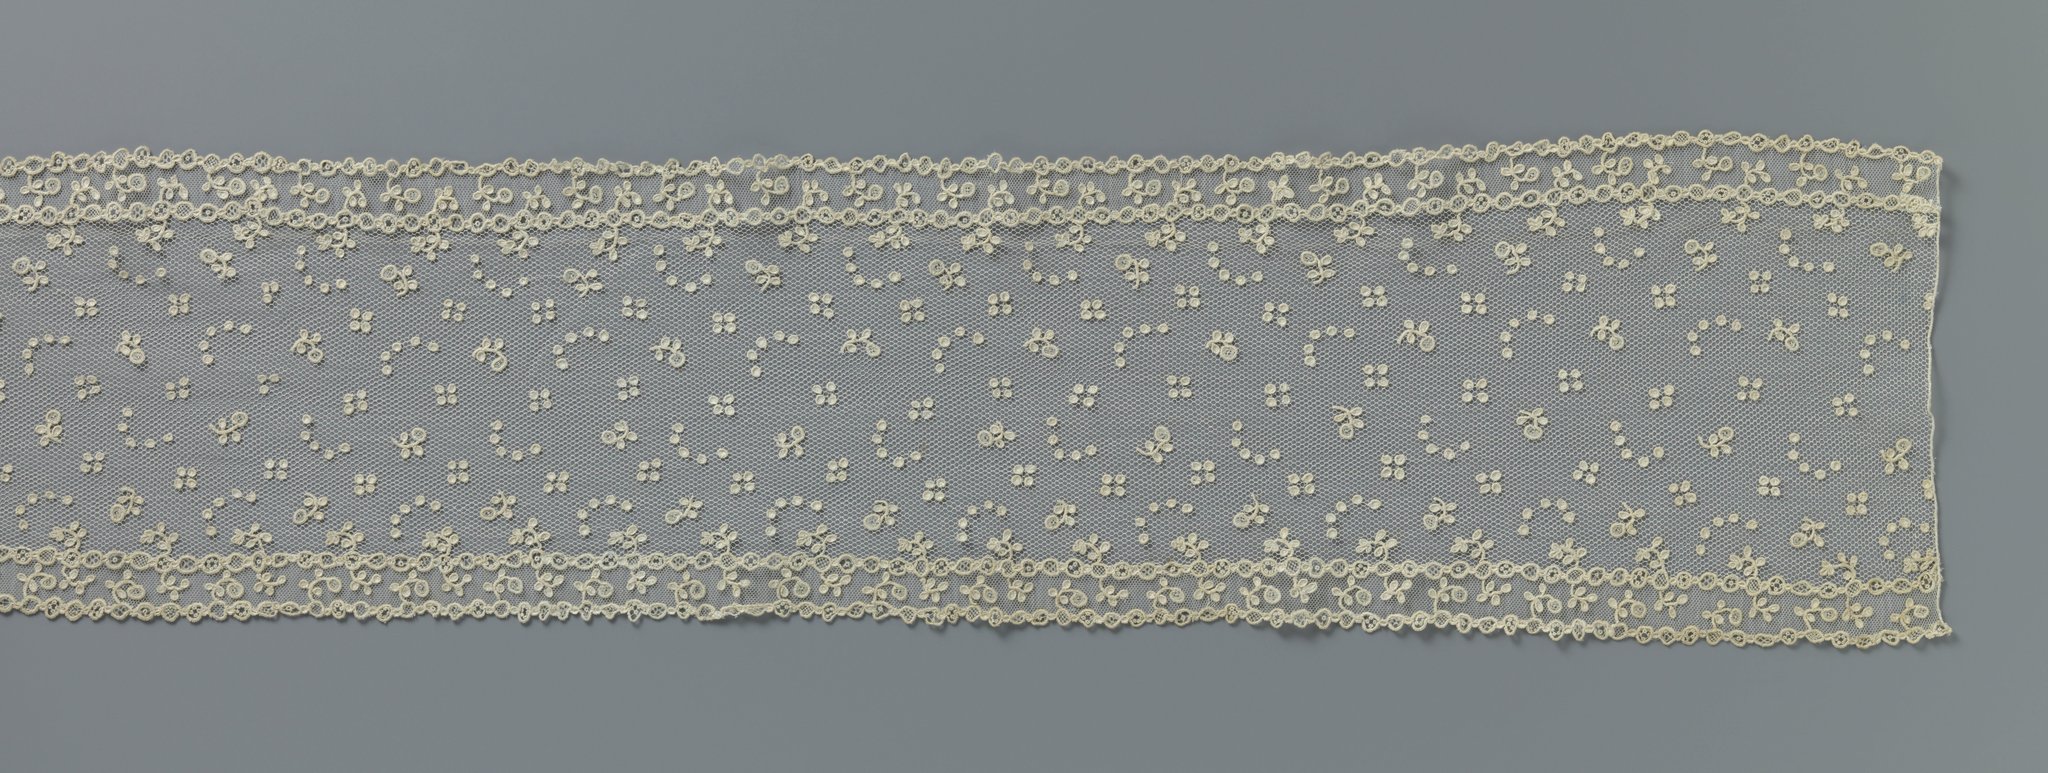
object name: japonslip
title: Japonslip met halve maantjes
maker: Anonymous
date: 1800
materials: linen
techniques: lace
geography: france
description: Op een grof maasgrond staat een strooipatroon van moesjes, die gegroepeerd zijn tot halve maantjes, quadrilles en madeliefjes. Een smalle rechte rand met fijne maasgrond sluit de buitenzijde af en is begrensd door parellijsten. Alençon-kant.